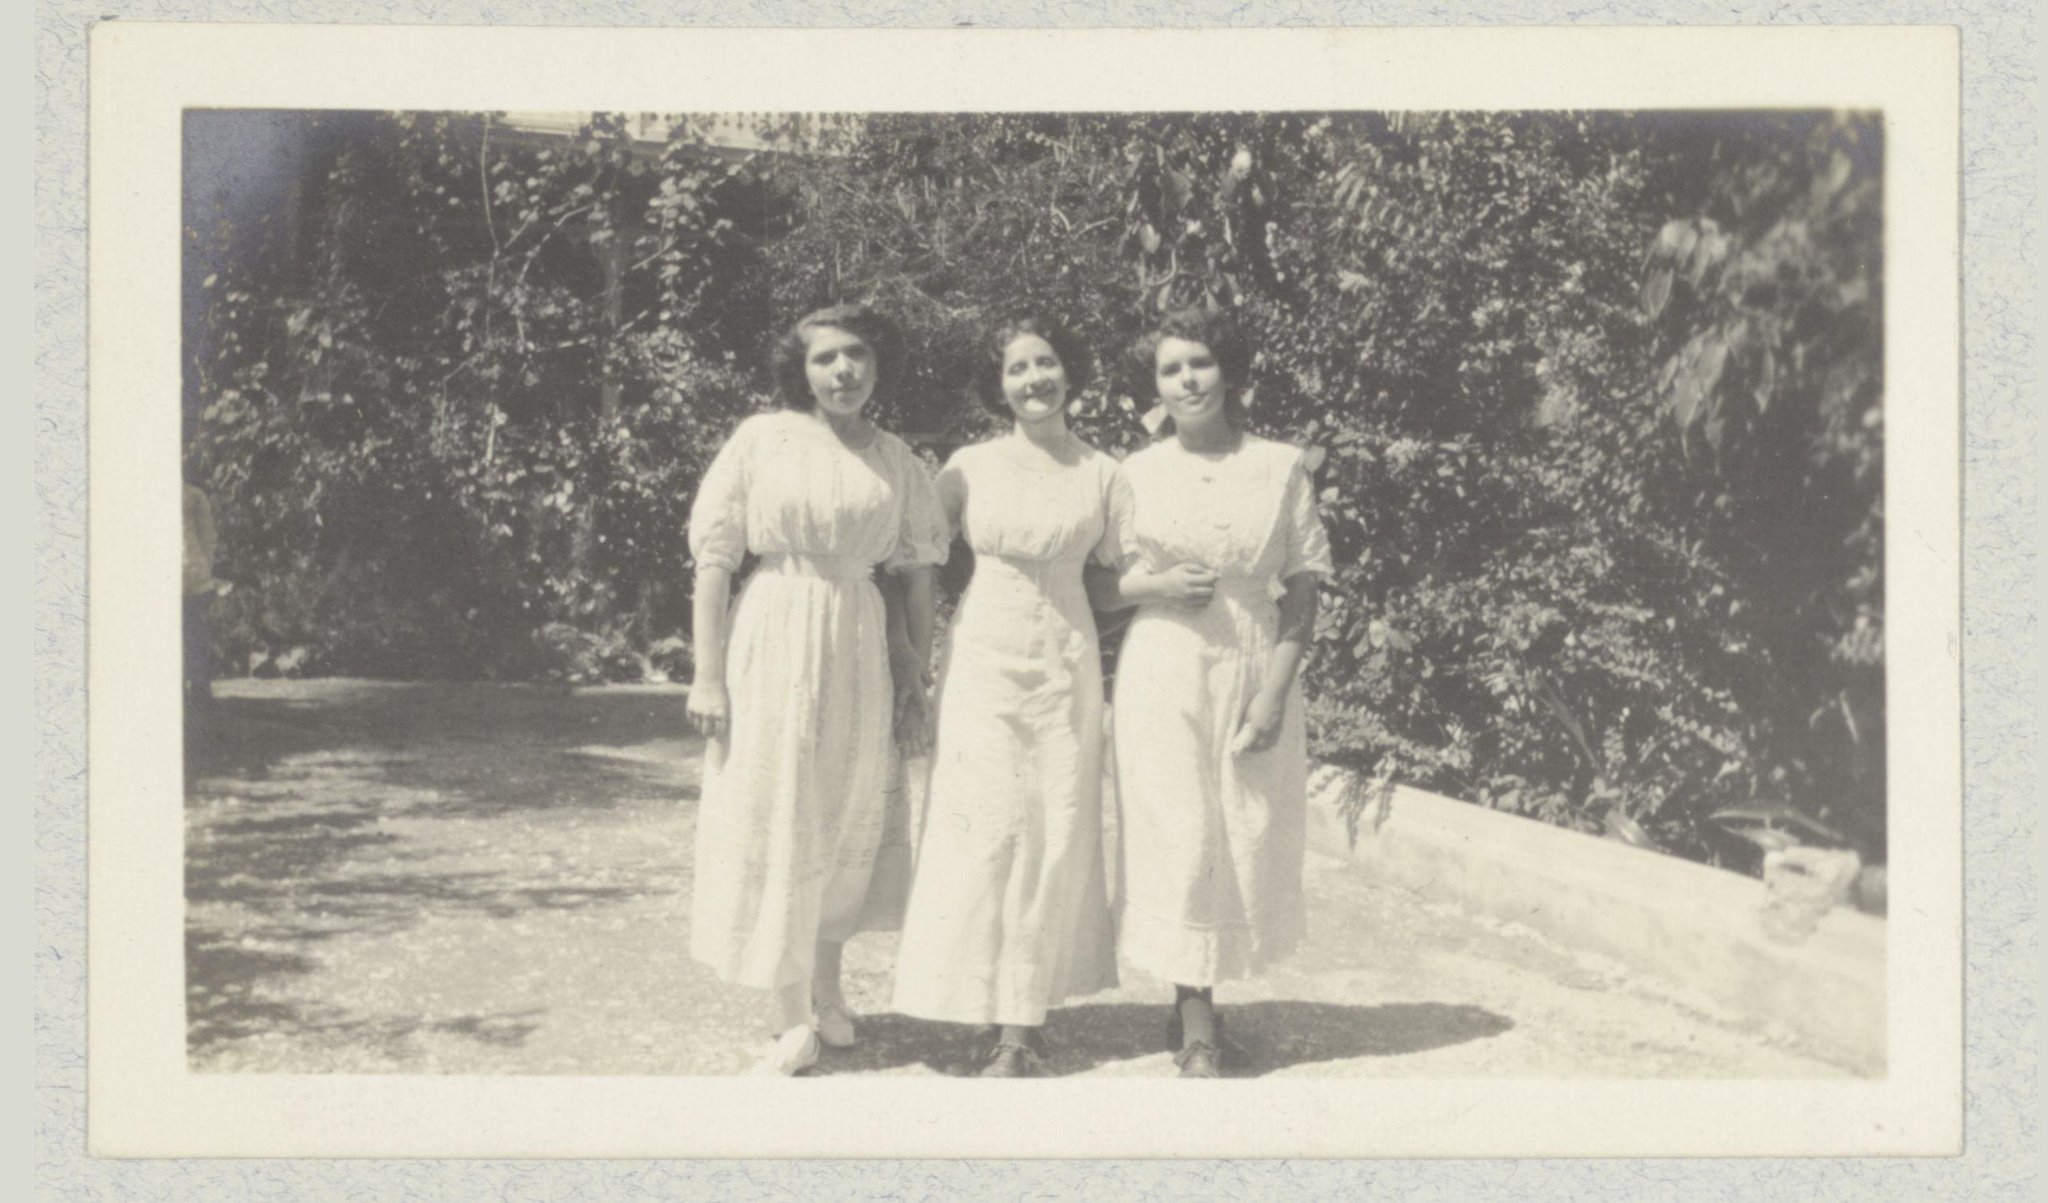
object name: photograph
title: Jongedames in Port-au-Prince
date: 1905-1912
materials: photographic support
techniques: photography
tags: port-au-prince, haïti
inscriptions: inscription: ‘Edith von Heydebrand und der Lasa / Fernande d'Aubignuy / Nini Coles / P. au P. Mei 1912’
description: Portret van drie jongedames die gearmd poseren bij een muurtje, in Port-au-Prince op Haïti, mei 1912. Onderdeel van het fotoalbum van de familie Boom-Gonggrijp in Suriname en Curaçao.